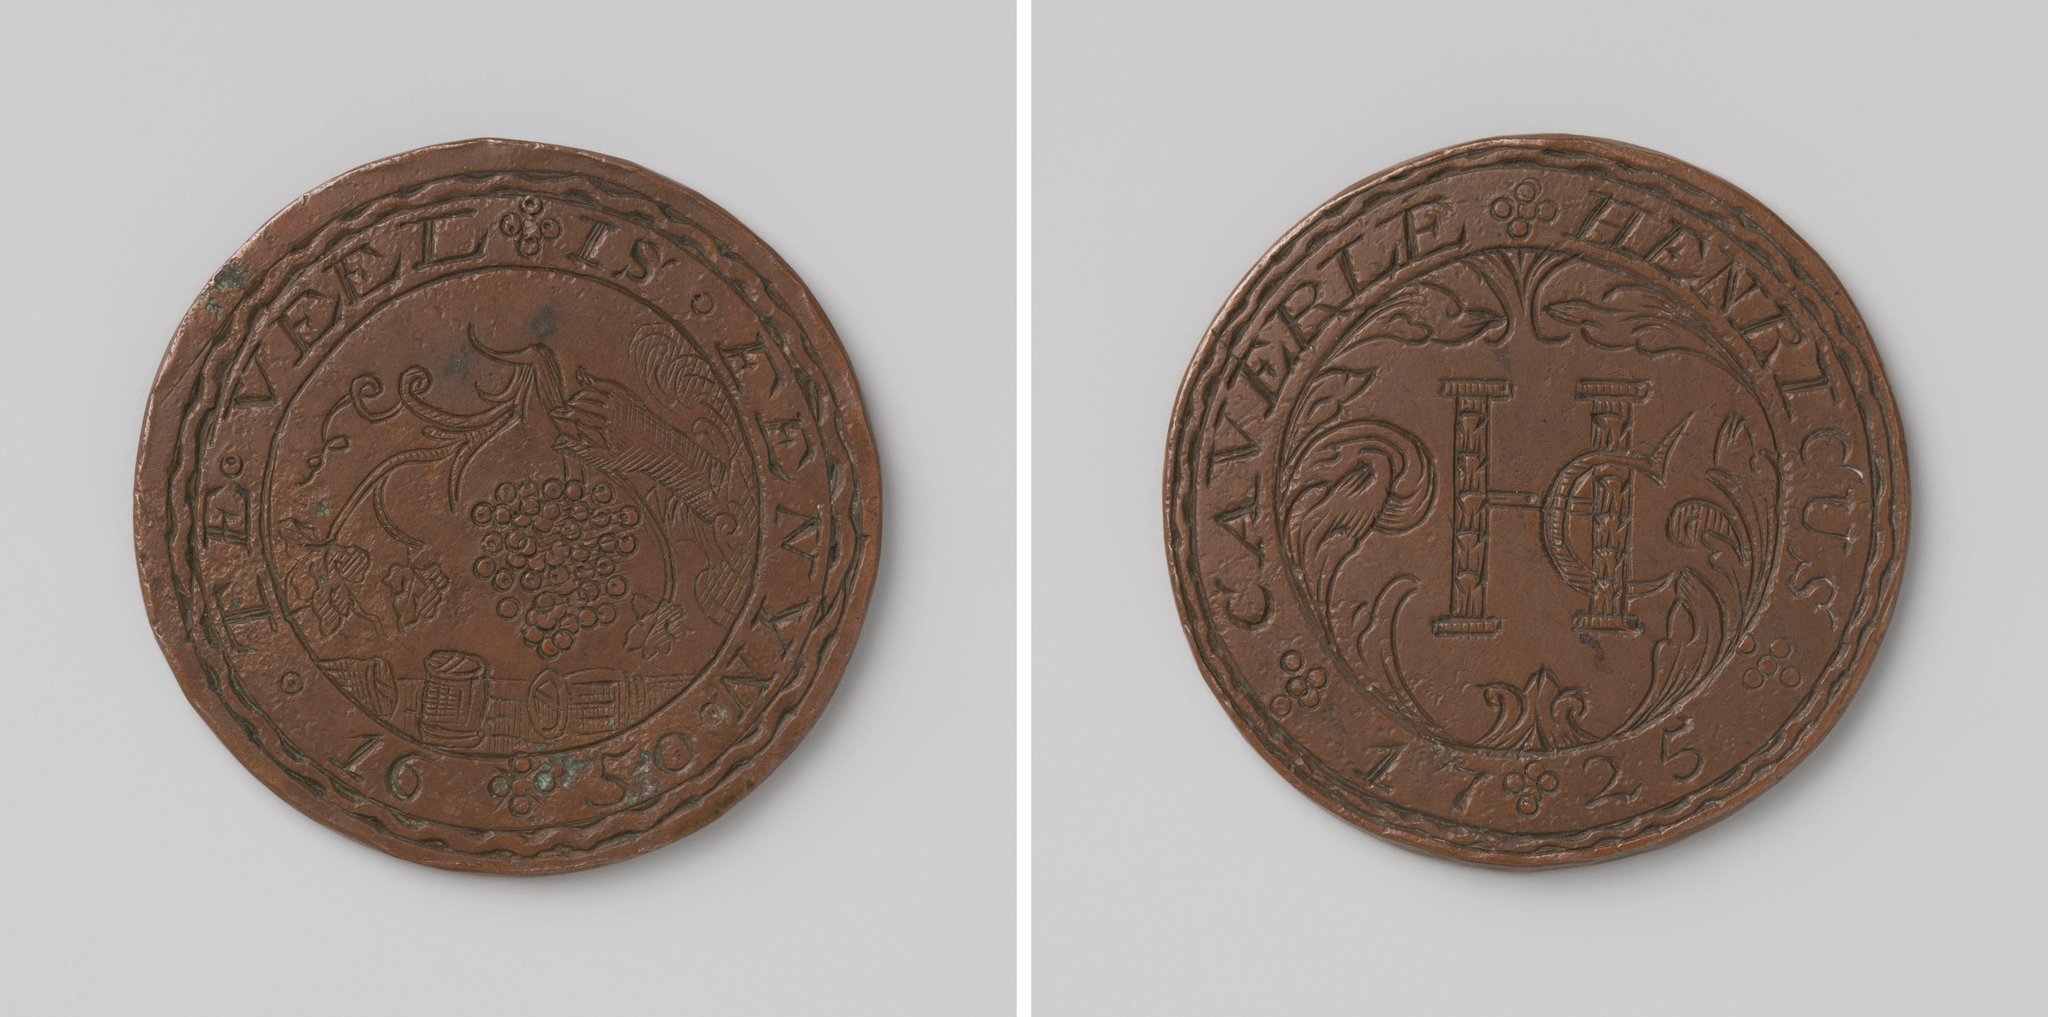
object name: medal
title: Wijnkopersgilde van Utrecht, gildepenning van Henricus Caverle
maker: Anonymous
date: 1725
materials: copper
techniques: engraving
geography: utrecht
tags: utrecht